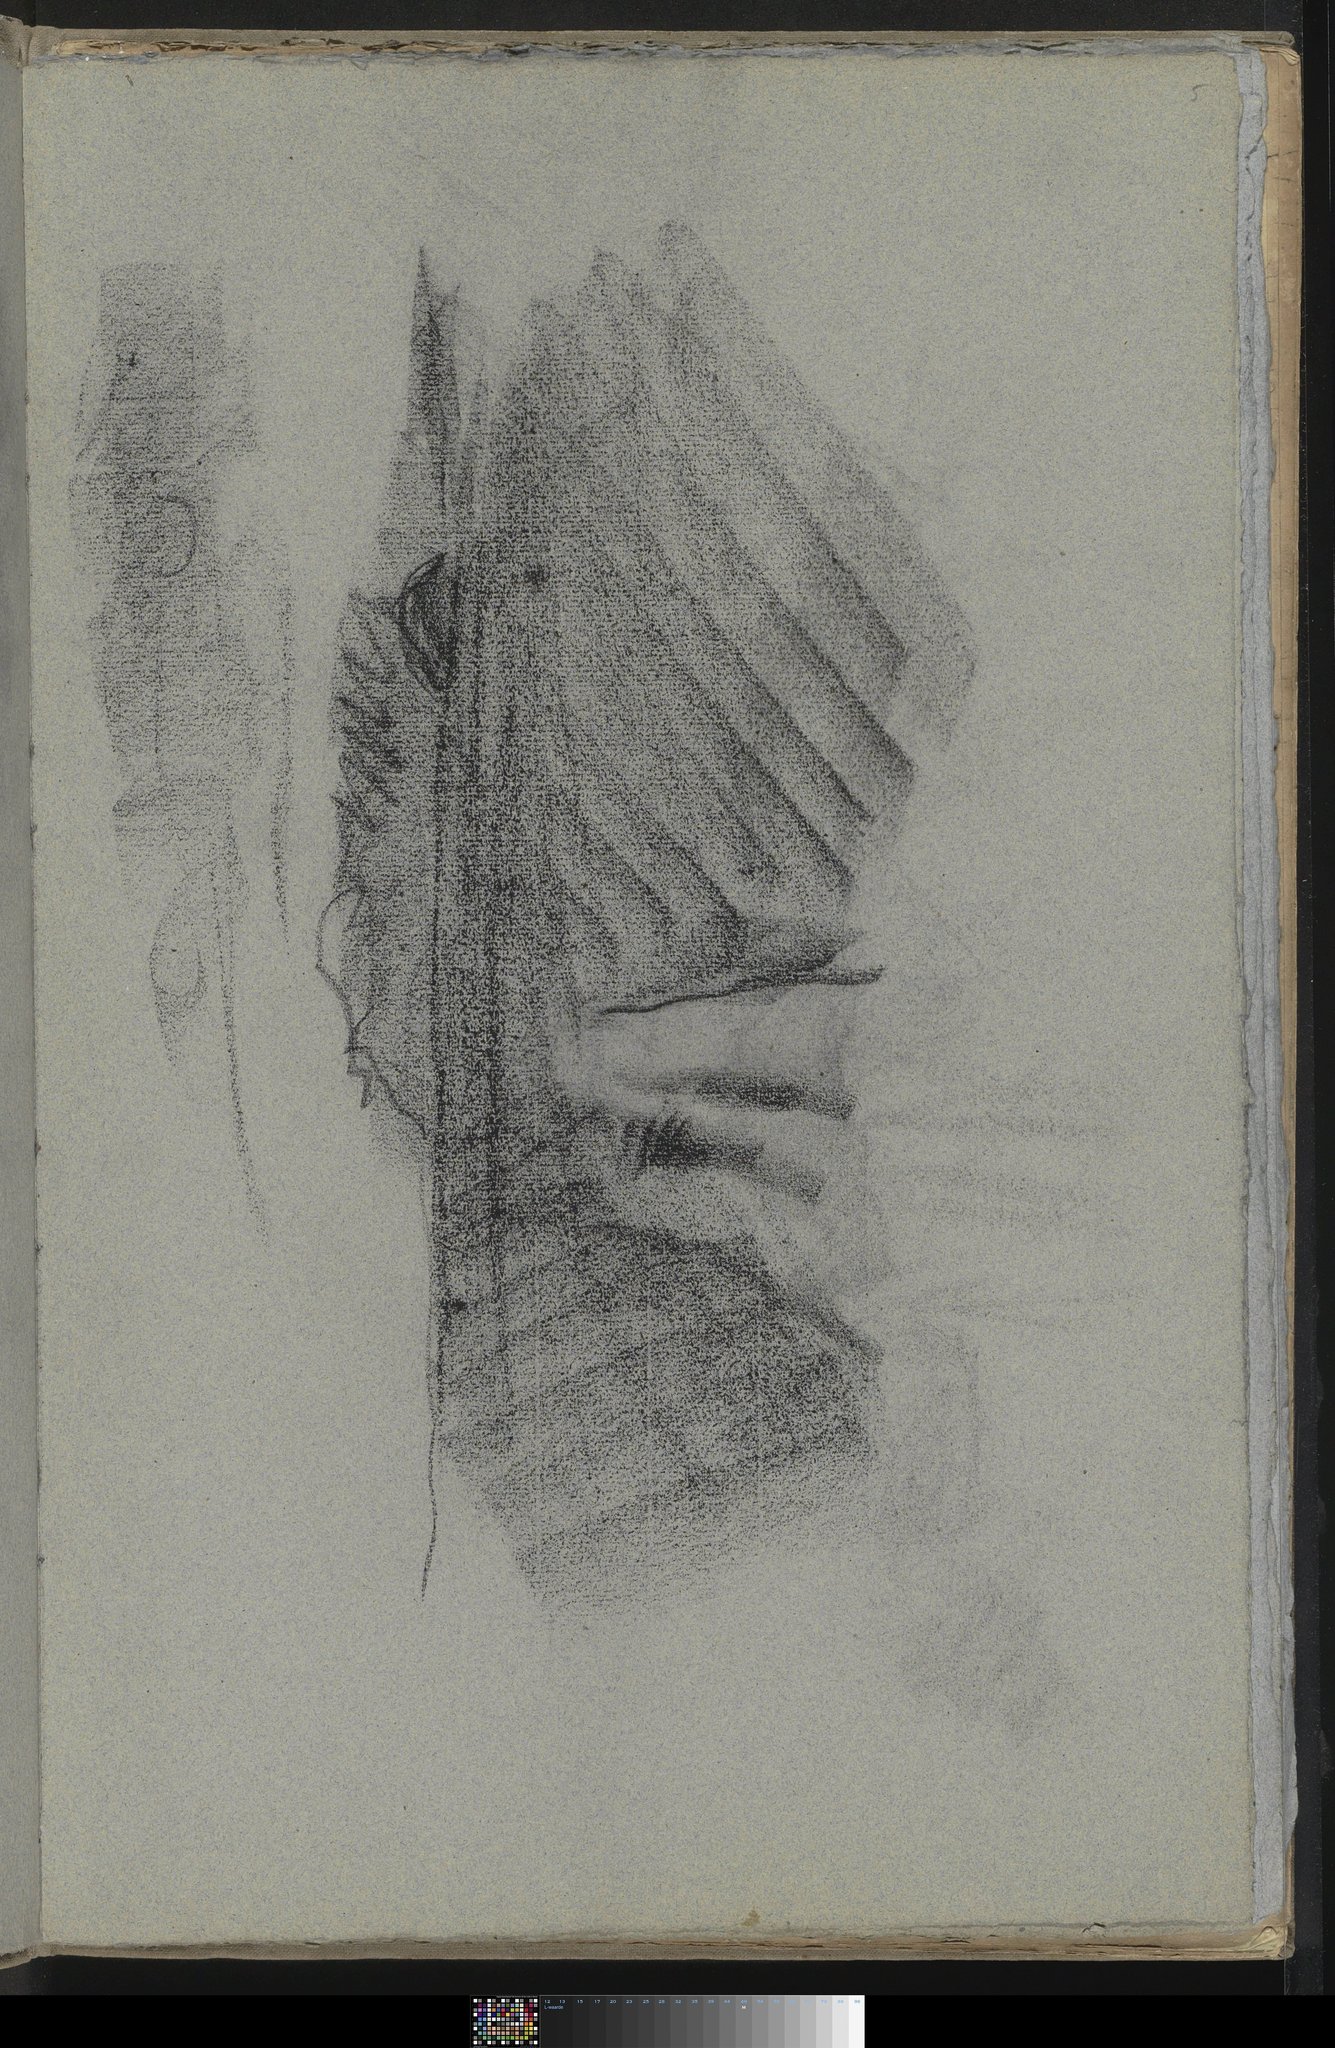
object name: sketchbook leaf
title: Landschap met een boerderij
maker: willem witsen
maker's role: draughtsman, painter, print maker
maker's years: 1860-1923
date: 1884-1887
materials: chalk, paper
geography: ewijkshoeve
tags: farm or solitary house in landscape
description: Pagina 5 uit een schetsboek met 45 bladen vervaardigd rond de Ewijkshoeve.